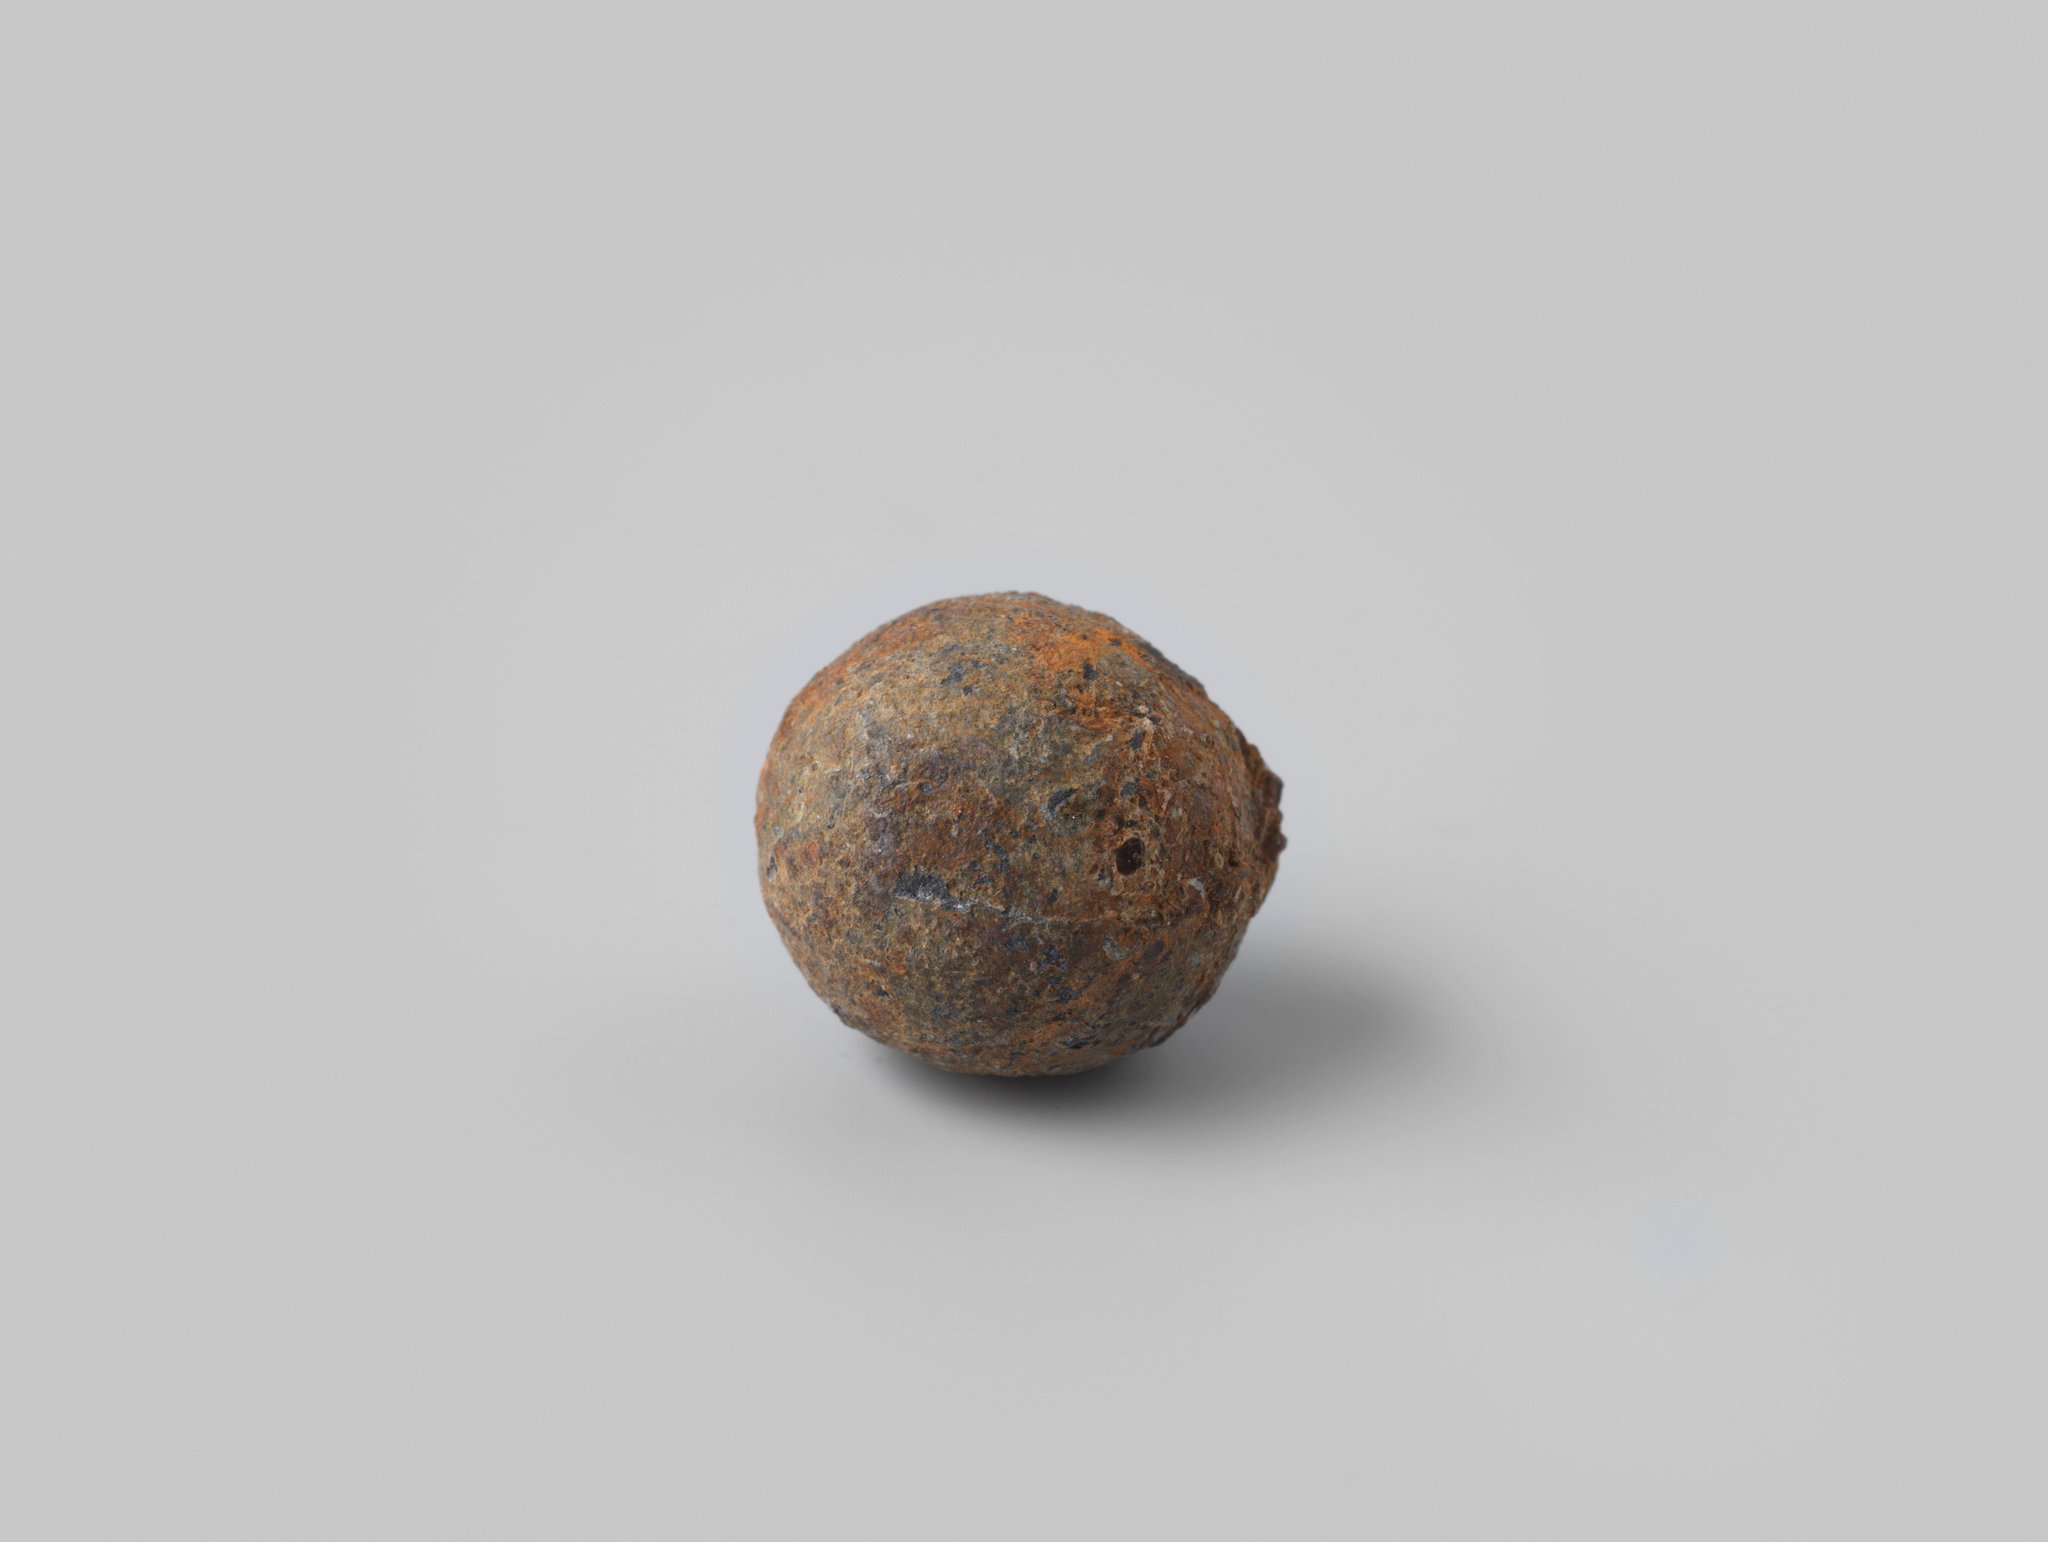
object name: bullet ammunition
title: Kogel uit het wrak van de Oost-Indiëvaarder Hollandia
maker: Anonymous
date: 1700-1743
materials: lead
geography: netherlands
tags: verenigde oostindische compagnie, hollandia (schip), annet